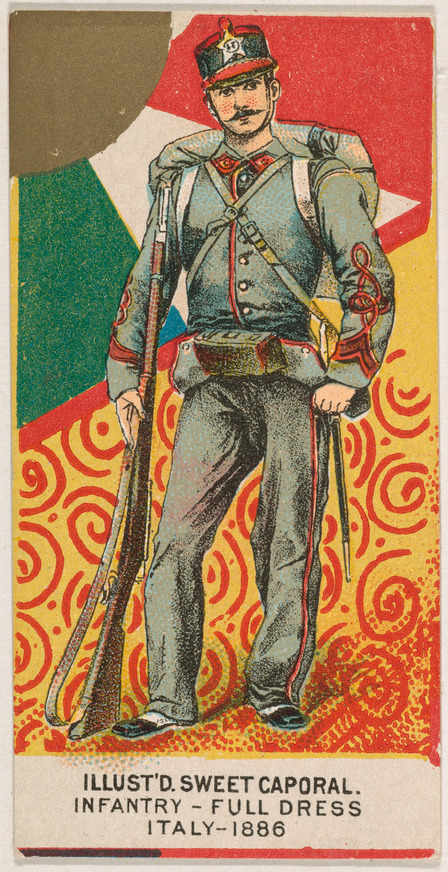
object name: print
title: Full Dress, Infantry, Italy, 1886, from the Military Series (N224) issued by Kinney Tobacco Company to promote Sweet Caporal Cigarettes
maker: kinney brothers tobacco company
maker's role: publisher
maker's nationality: american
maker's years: 1869-2011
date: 1888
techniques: color lithograph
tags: military,men